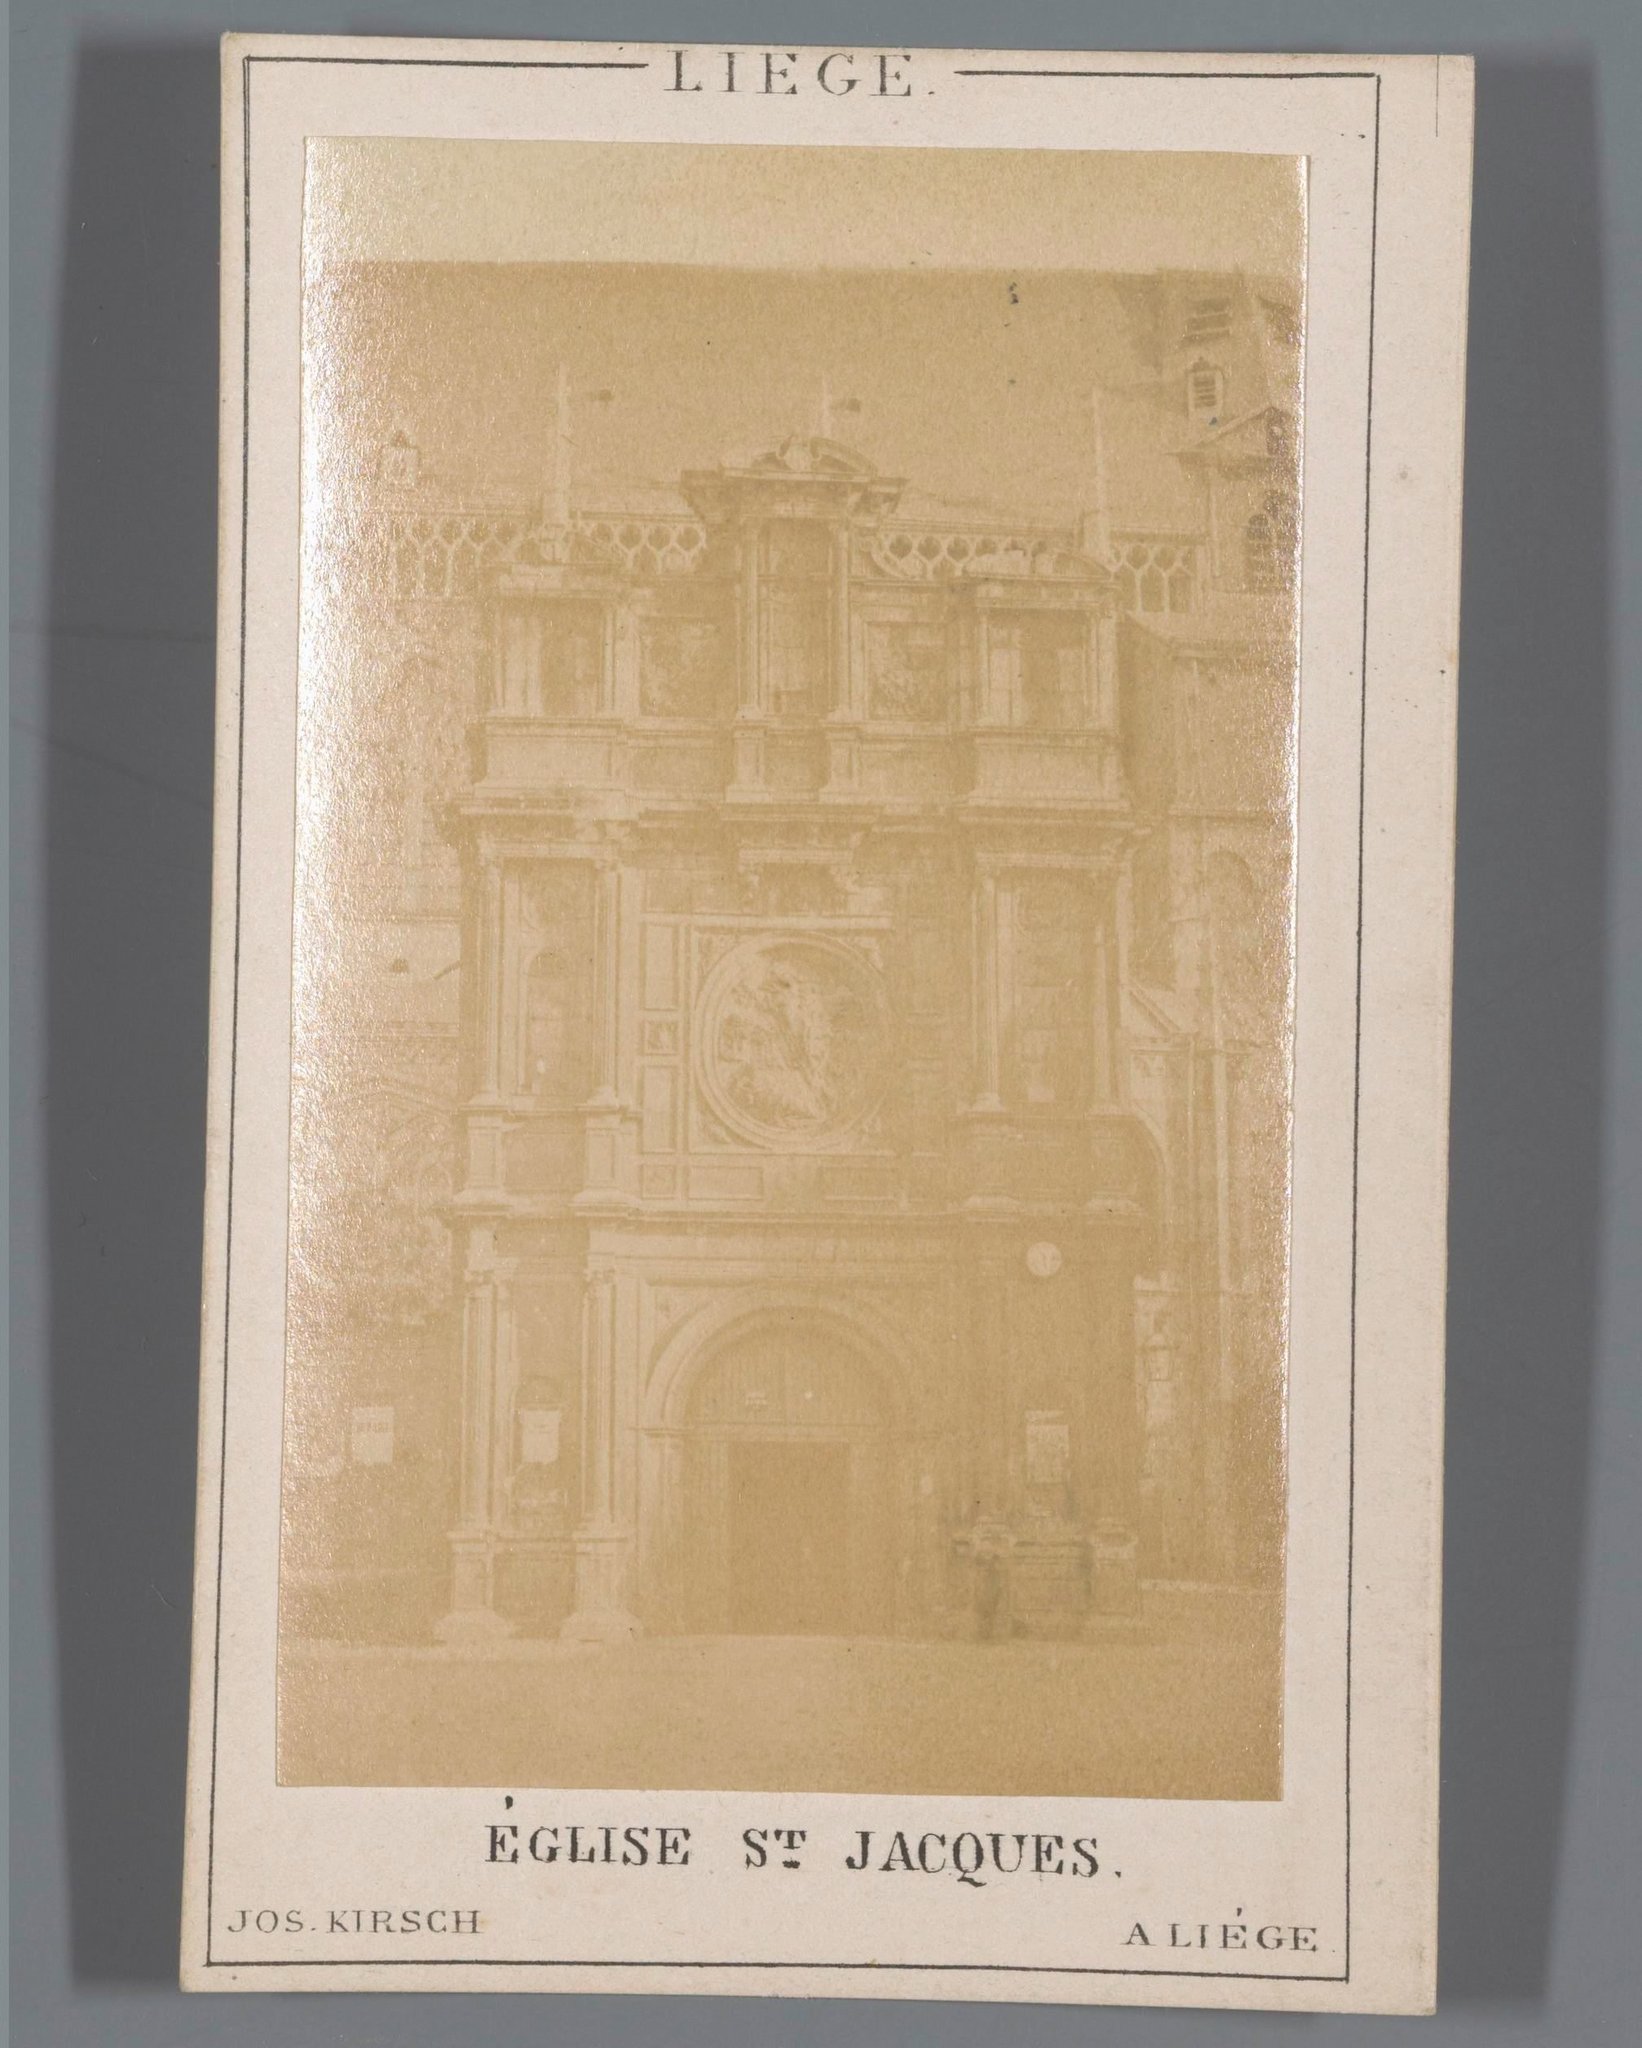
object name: photograph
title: Liège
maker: joseph kirsch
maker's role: fotograaf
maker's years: 1826-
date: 1862-1894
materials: cardboard, paper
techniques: albumen print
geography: liège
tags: parts of church exterior and annexes: portal